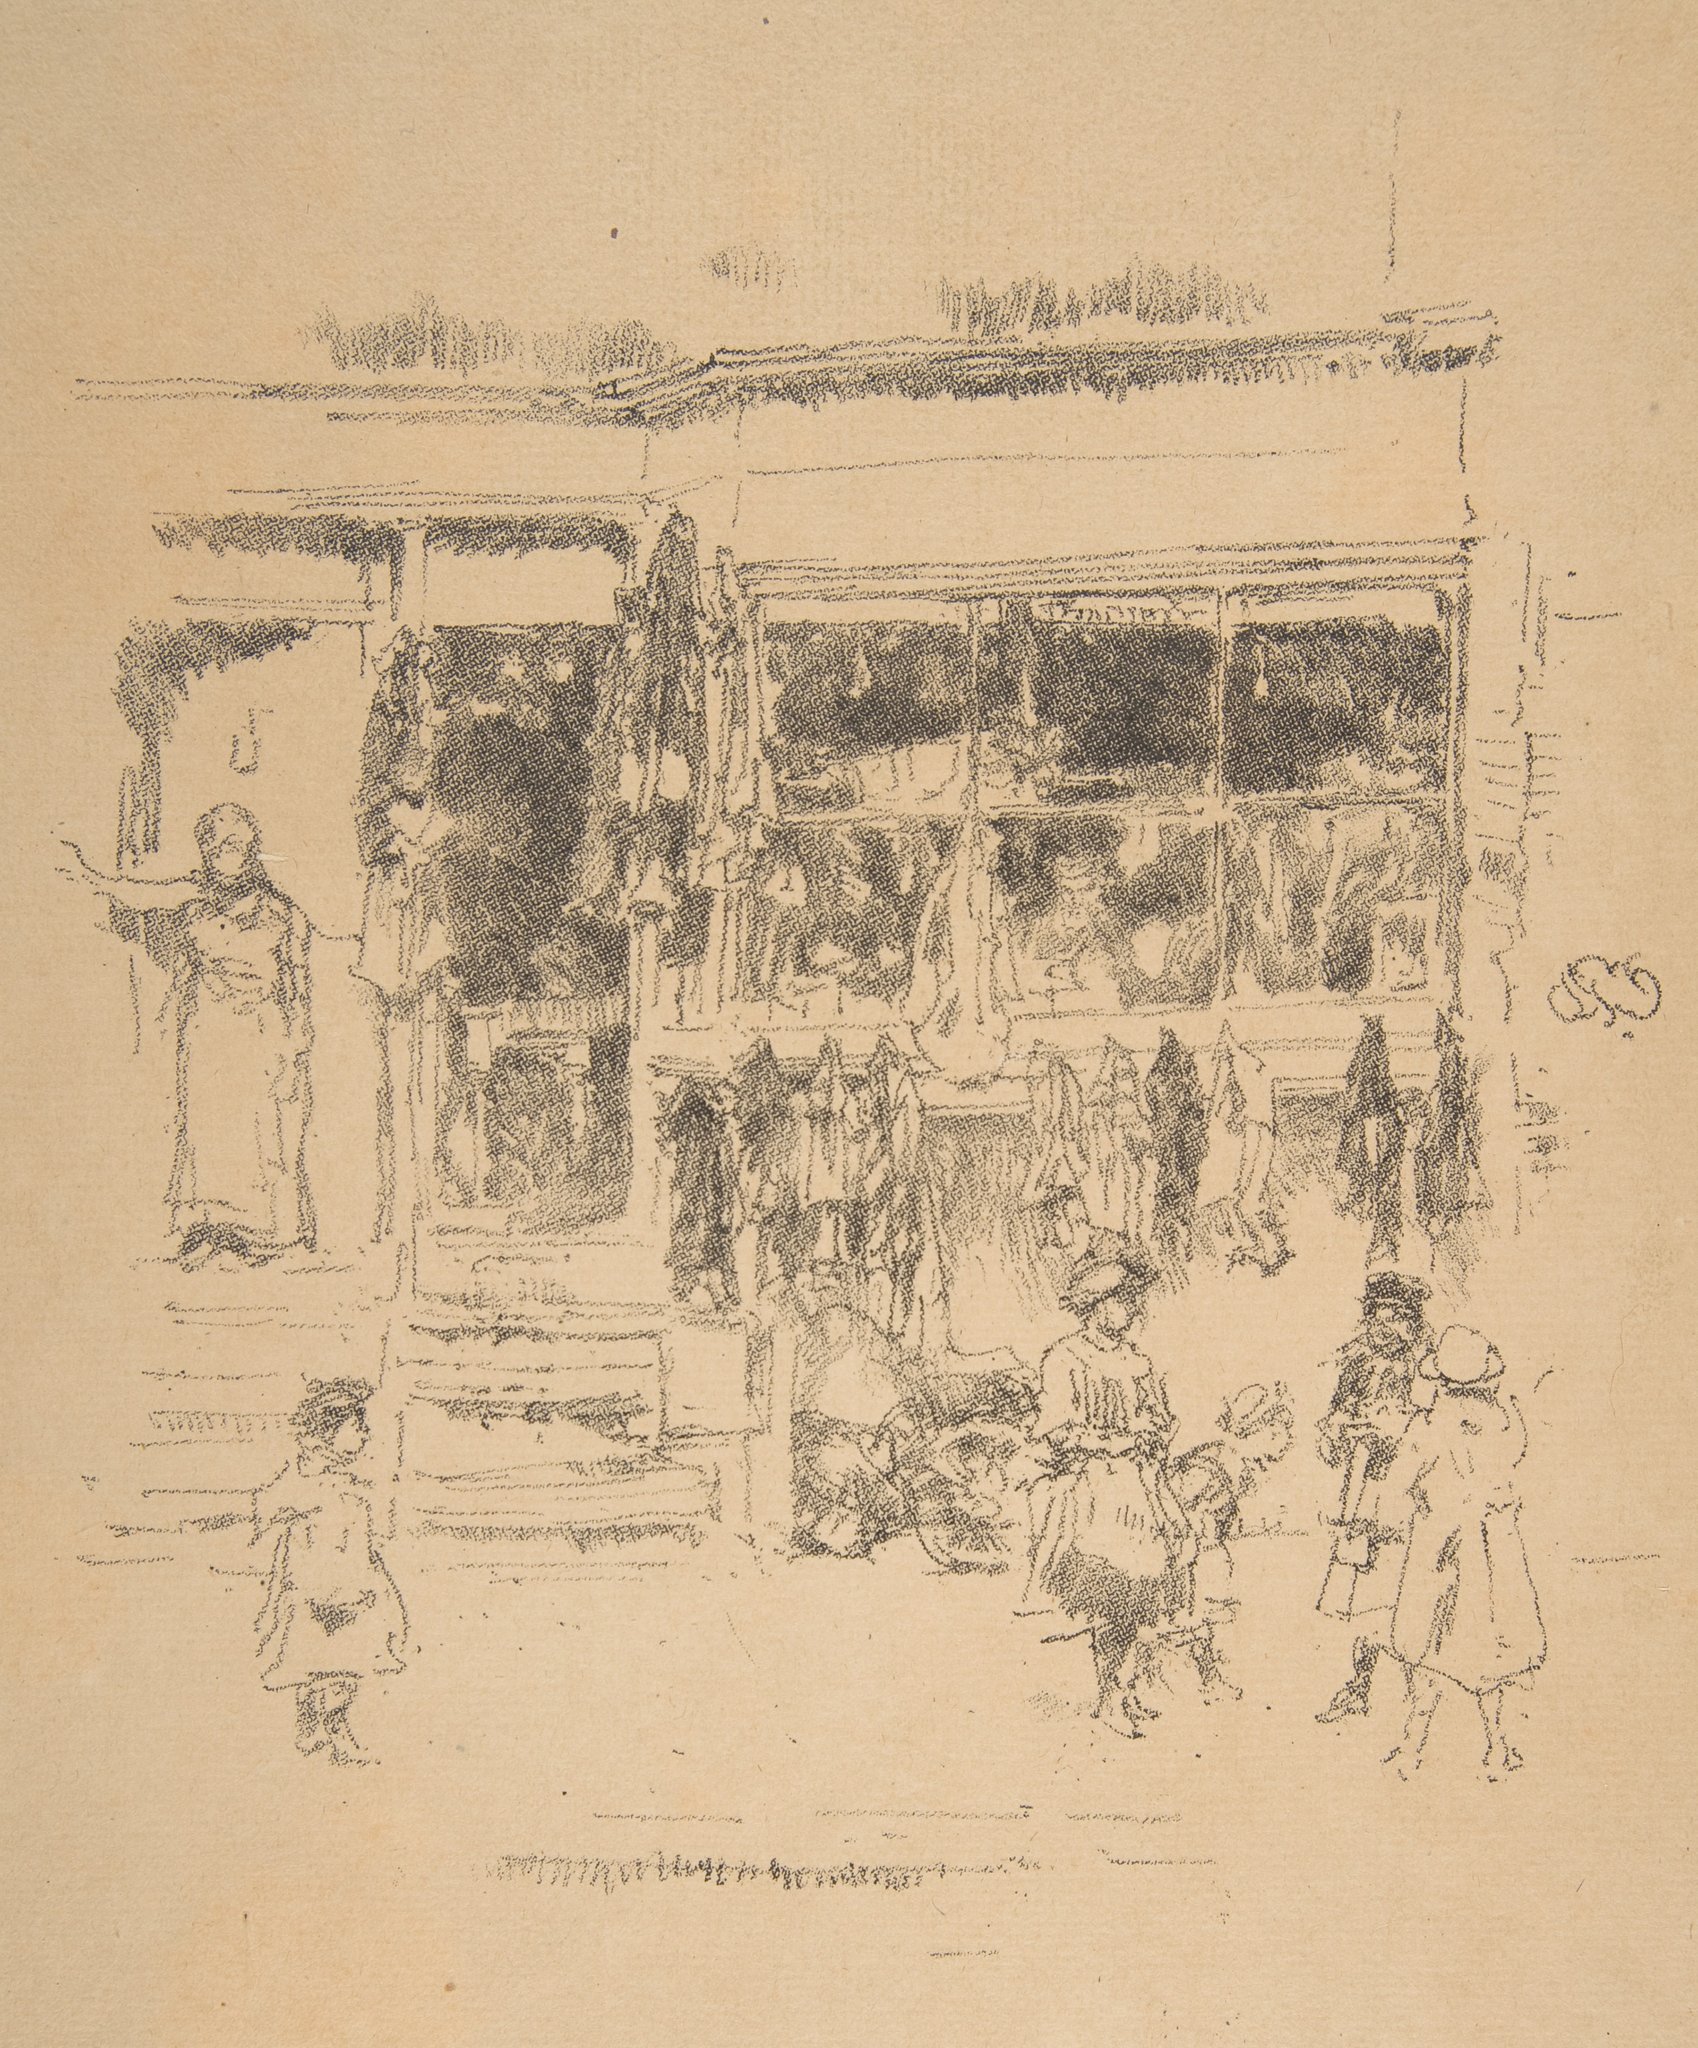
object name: print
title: Chelsea Rags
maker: james mcneill whistler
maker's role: artist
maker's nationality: american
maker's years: 1834-1903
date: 1888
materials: ink, paper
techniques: printing, lithography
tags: men,women